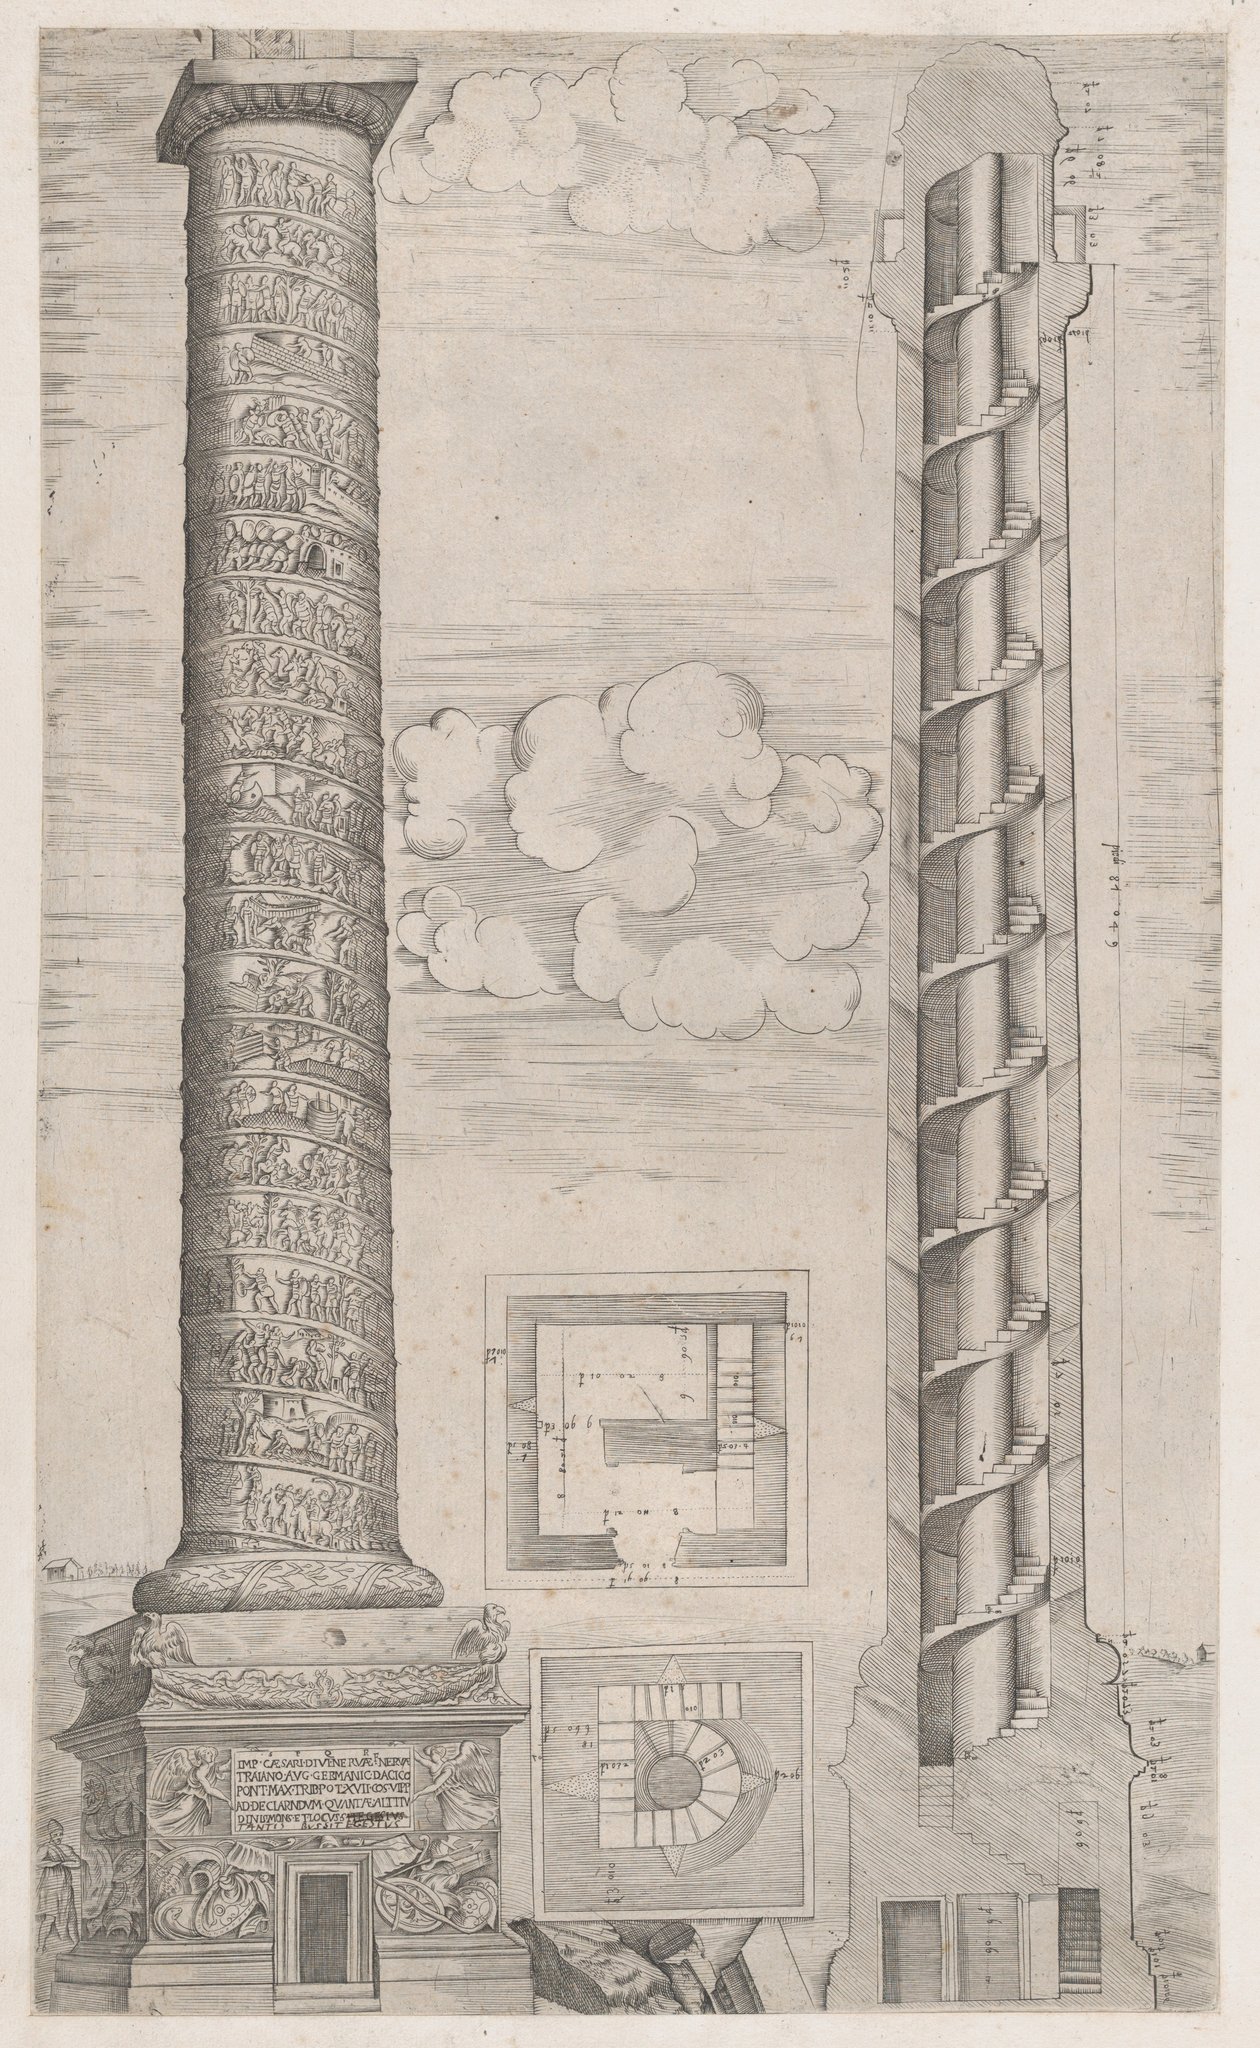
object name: print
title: Column of Trajan, from "Speculum Romanae Magnificentiae"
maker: Anonymous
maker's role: artist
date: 1501-1600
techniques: engraving, etching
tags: architecture,columns,rome